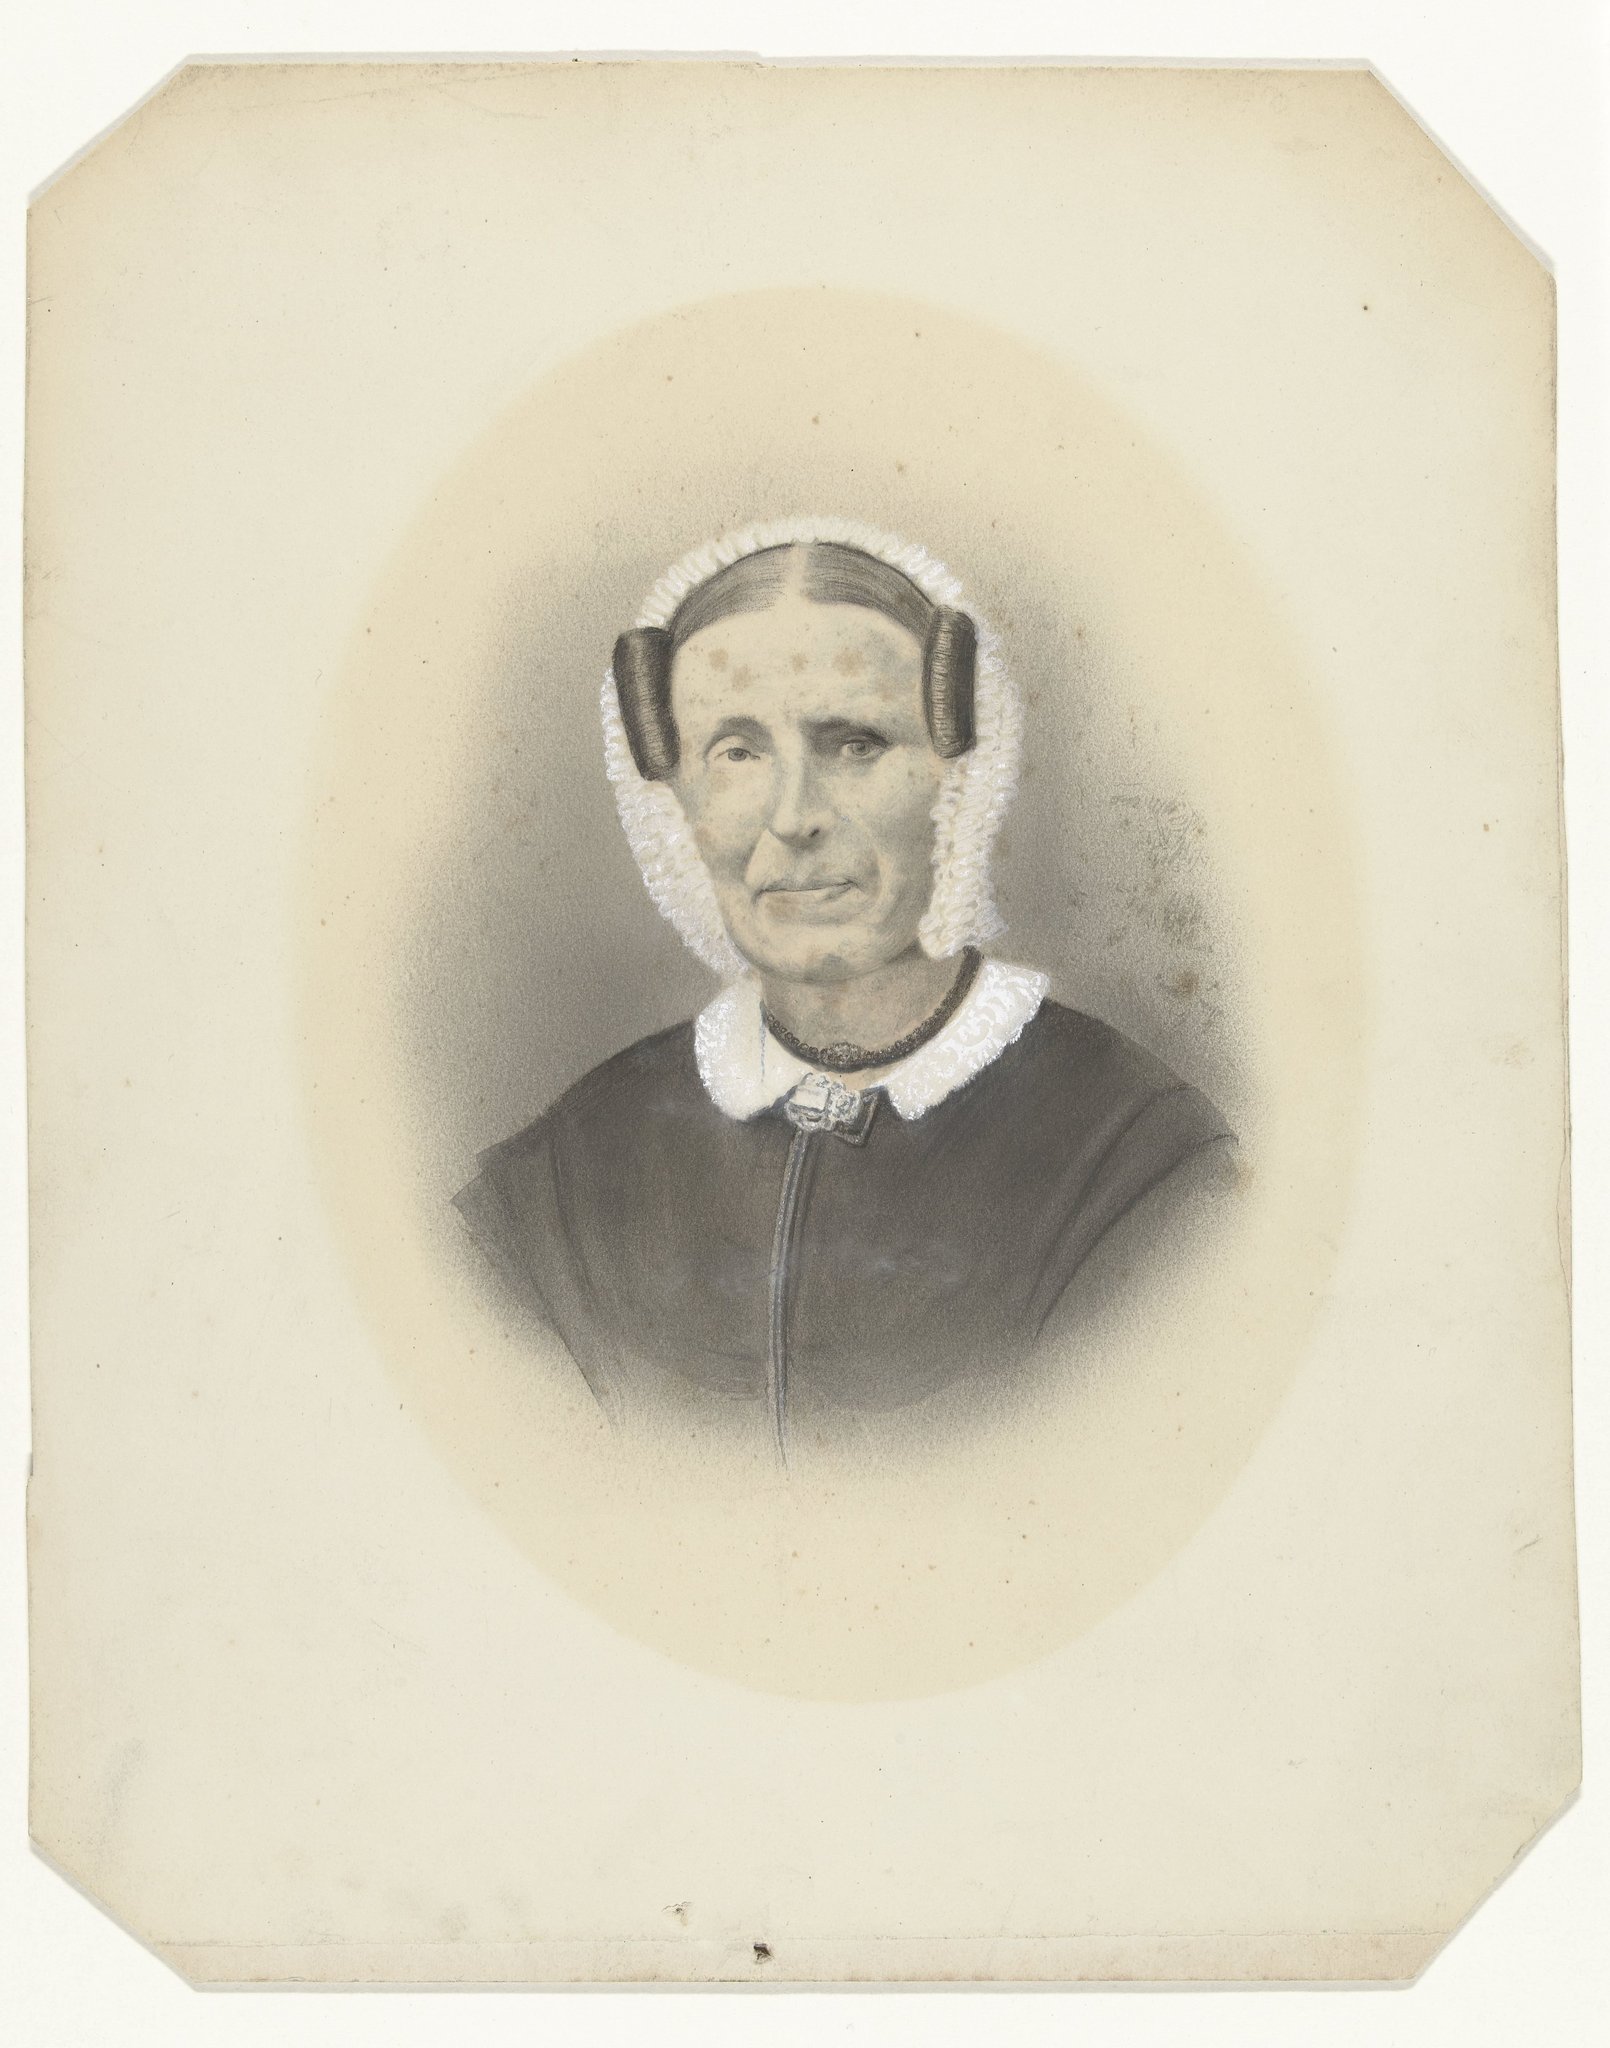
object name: photograph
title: Ingekleurd portret van een vrouw in klederdracht met witte kap en witte kraag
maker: Anonymous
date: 1870-1900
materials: paper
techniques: albumen print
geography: netherlands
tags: historical persons not known by name - bb - woman, folk costume, regional costume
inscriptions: title: ‘overgrootmoeder Ger’